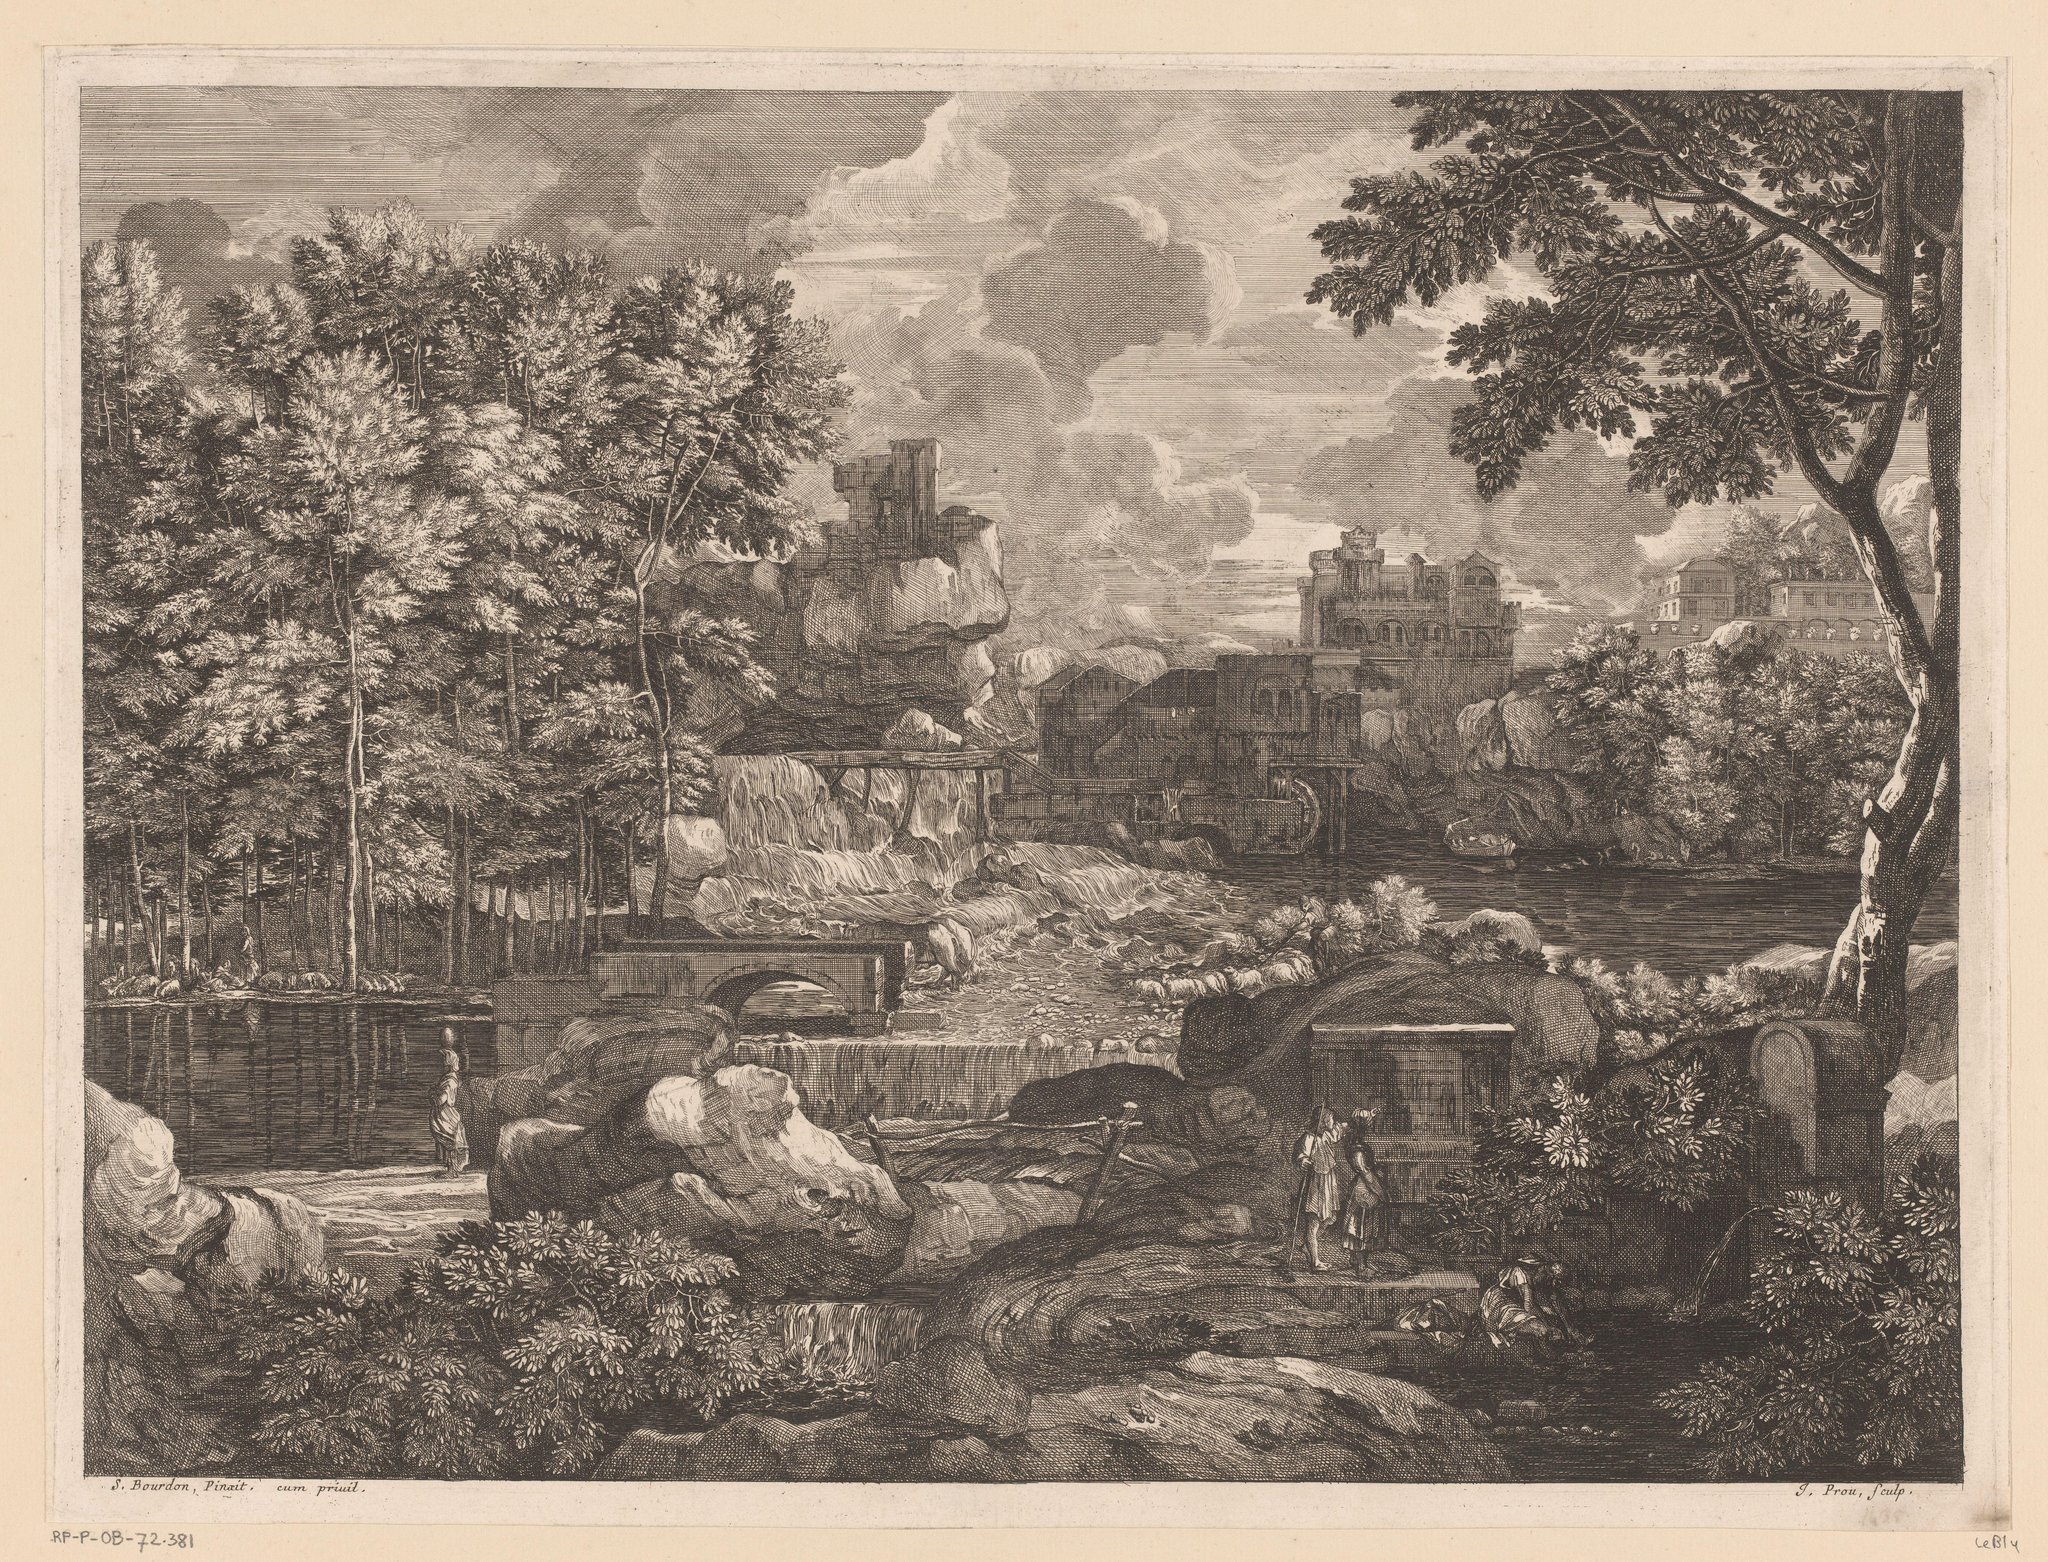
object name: print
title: Rivierlandschap met schaapskudde en op de achtergrond enkele gebouwen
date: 1634-1686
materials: paper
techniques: etching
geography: france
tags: landscapes with waters, waterscapes, seascapes (in the temperate zone)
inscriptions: collector's mark: Lugt 240